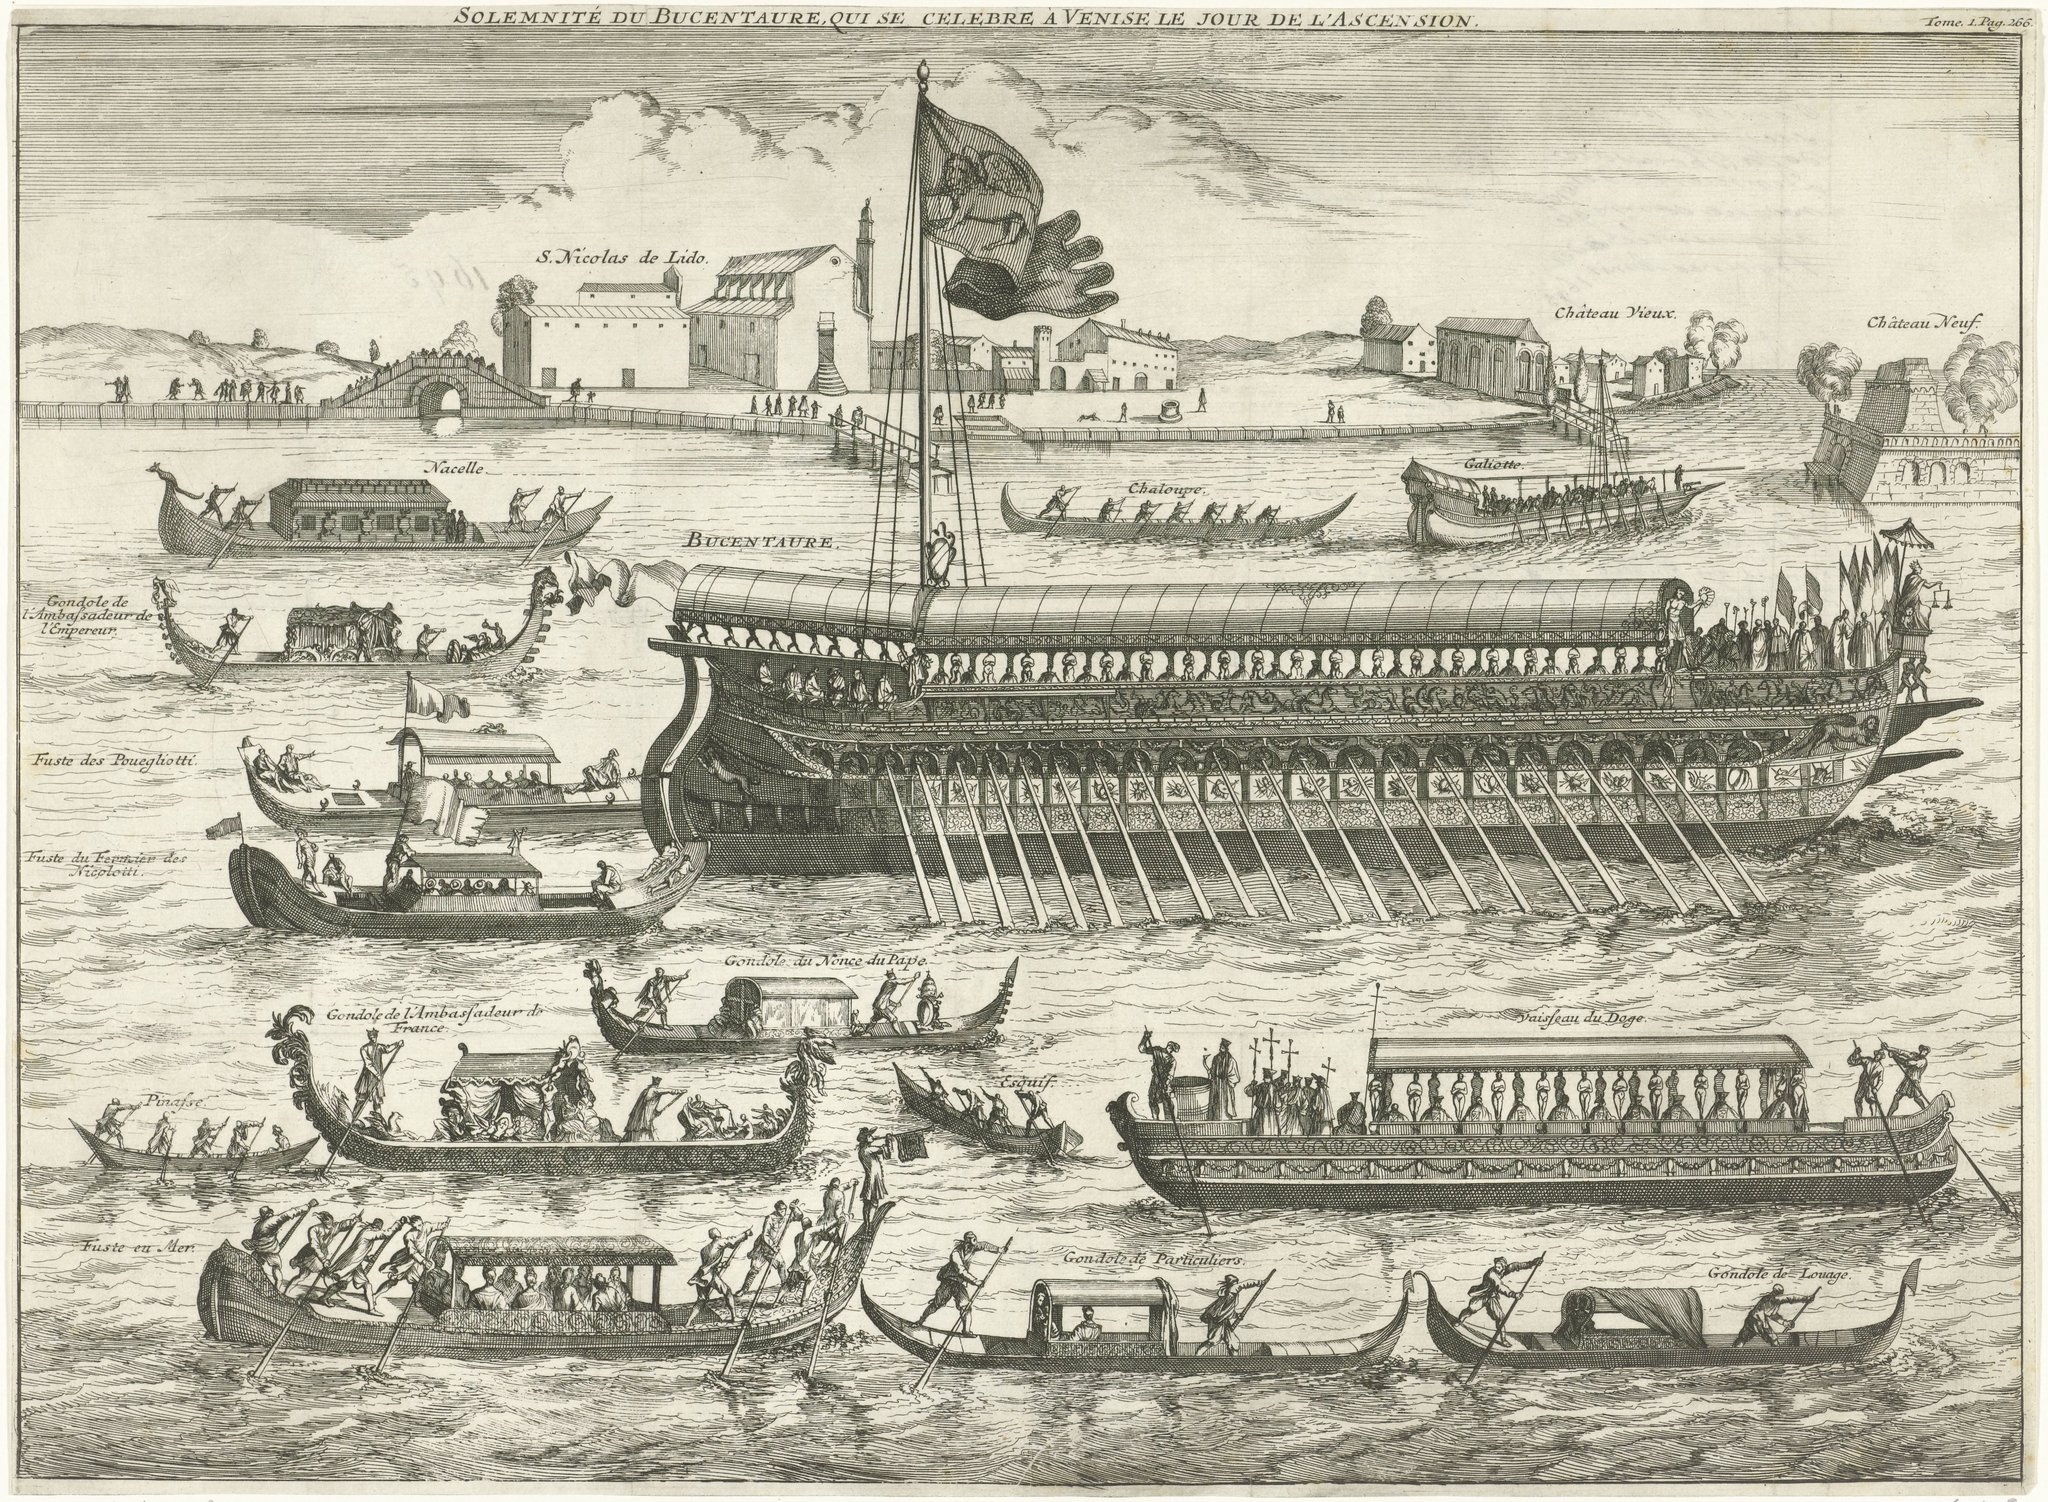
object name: book illustration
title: Solemnité du Bucentaure, qui se celebre a Venise le jour de l'Ascension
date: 1695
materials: paper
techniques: etching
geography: amsterdam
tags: gondola, trireme, galley, venice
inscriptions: collector's mark: Lugt 2228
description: Illustratie uit: Amelot de La Houssaie, Abraham Nicolas. Histoire du gouvernement de Venise. Amsterdam: Pieter Mortier (I), 1695.